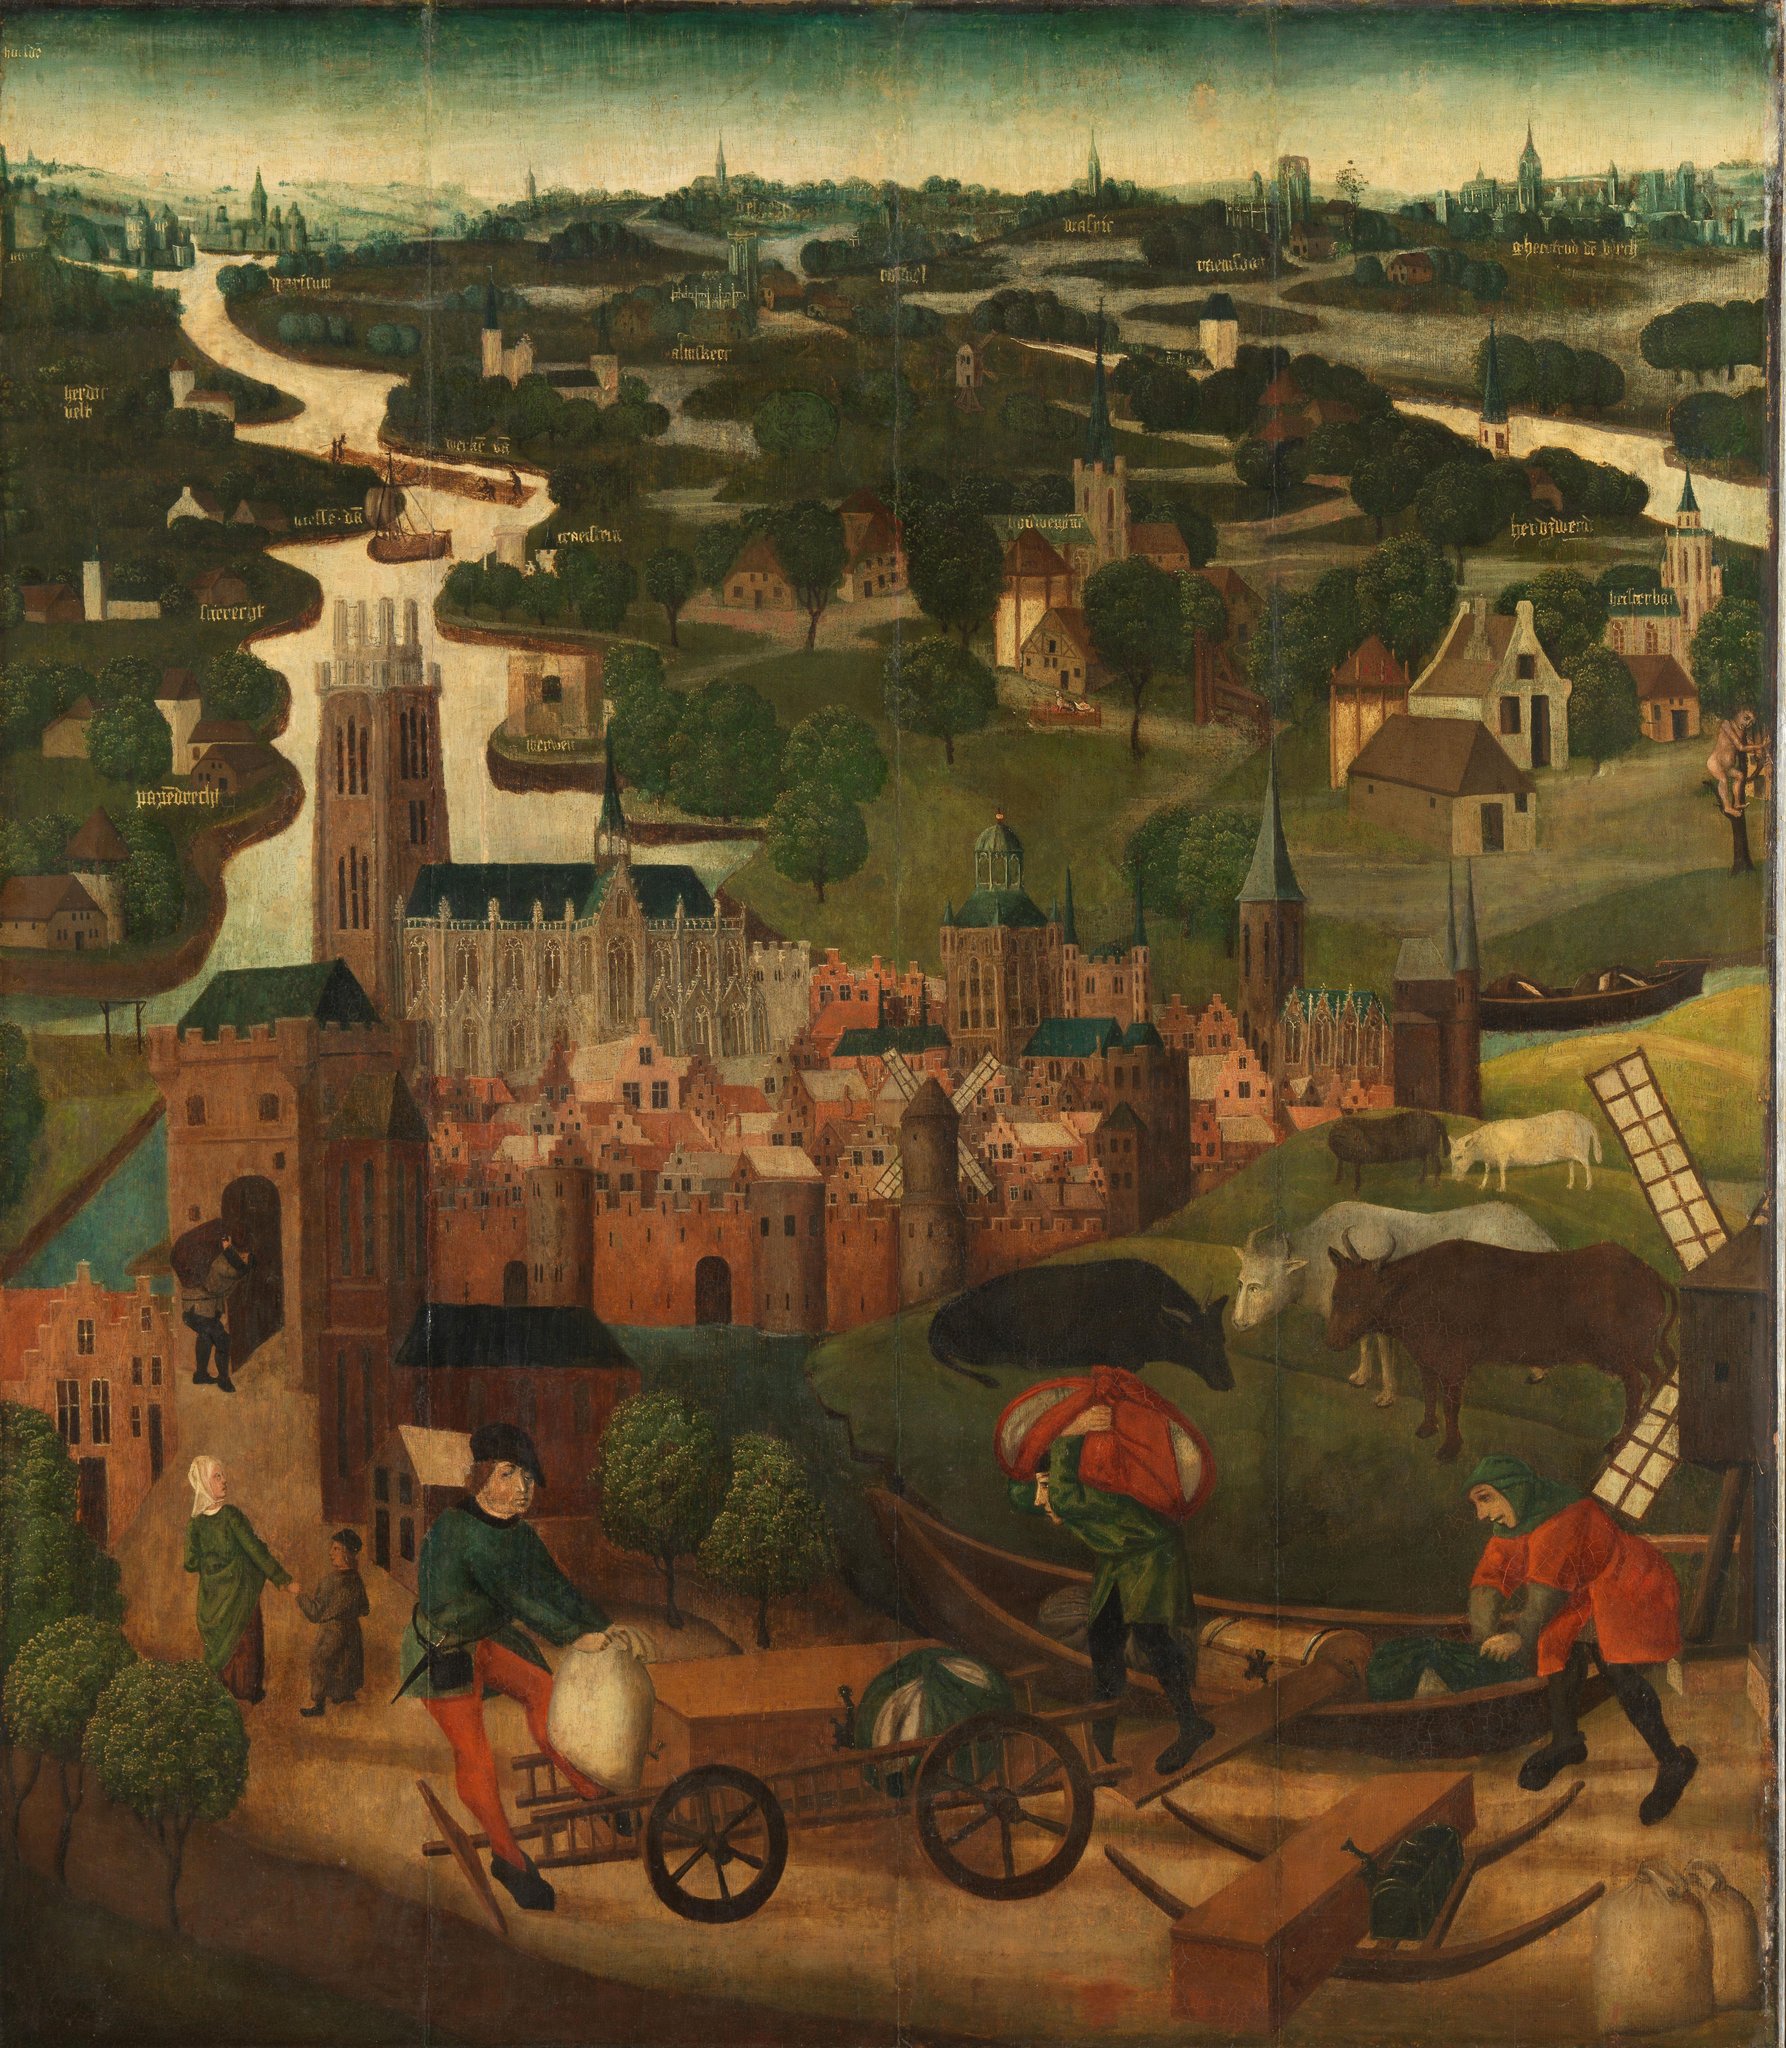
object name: painting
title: The Saint Elizabeth’s Day Flood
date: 1490-1495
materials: oil, panel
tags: rescue work during a flood, dike-break, dordrecht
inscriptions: inscription, throughout the painting: ‘gorcum// wo[a?]ricum (Workum) // almskerc (Almkerk) // [illegible] // cappel (Capelle) // waspic (Waspik) // [onleesbaar] // raemsdo. (Raamsdonk) // gheertrud de[n] berch (Geertruidenberg) // herdicvelt (Hardinxveld) // giesse[n]?da[m] // wercke[n] da[m] (Werkendam) // slierecht (Sliedrecht) // craeistein (Crayesteyn) // houwenig[en?] (Houweningen) // herdzwerd (Harradeswerde) // heisterbac (heysterbach) // pape[n]drecht // merwen (Huis te Merwede) // huesde[n] (Heusden)’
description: On the night of 19 November 1421 – the feast day of Saint Elizabeth – much of Holland was flooded. The Dordrecht region was badly hit: 23 villages were submerged and 2,000 people died. The survivors later had an altarpiece made. The outer panels depict the disaster, with the breach of the dike on the right and the undamaged town of Dordrecht on the left.